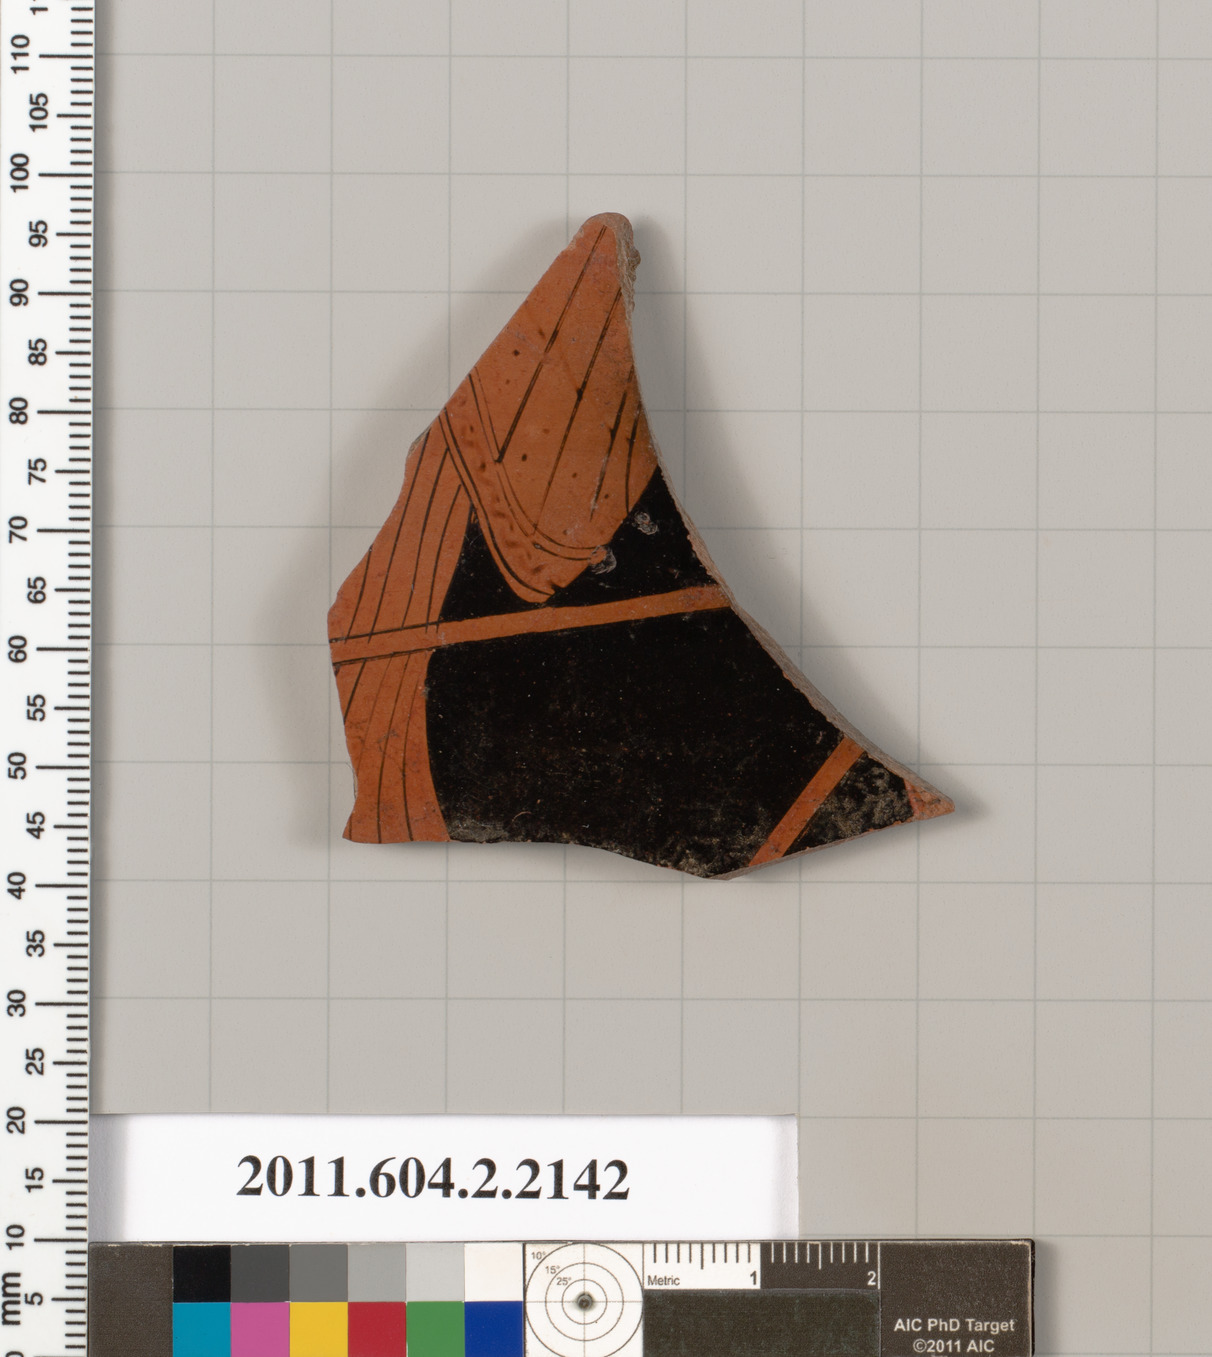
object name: pot fragment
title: Terracotta fragment of a pot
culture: greek, attic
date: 450-426 BCE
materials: terracotta